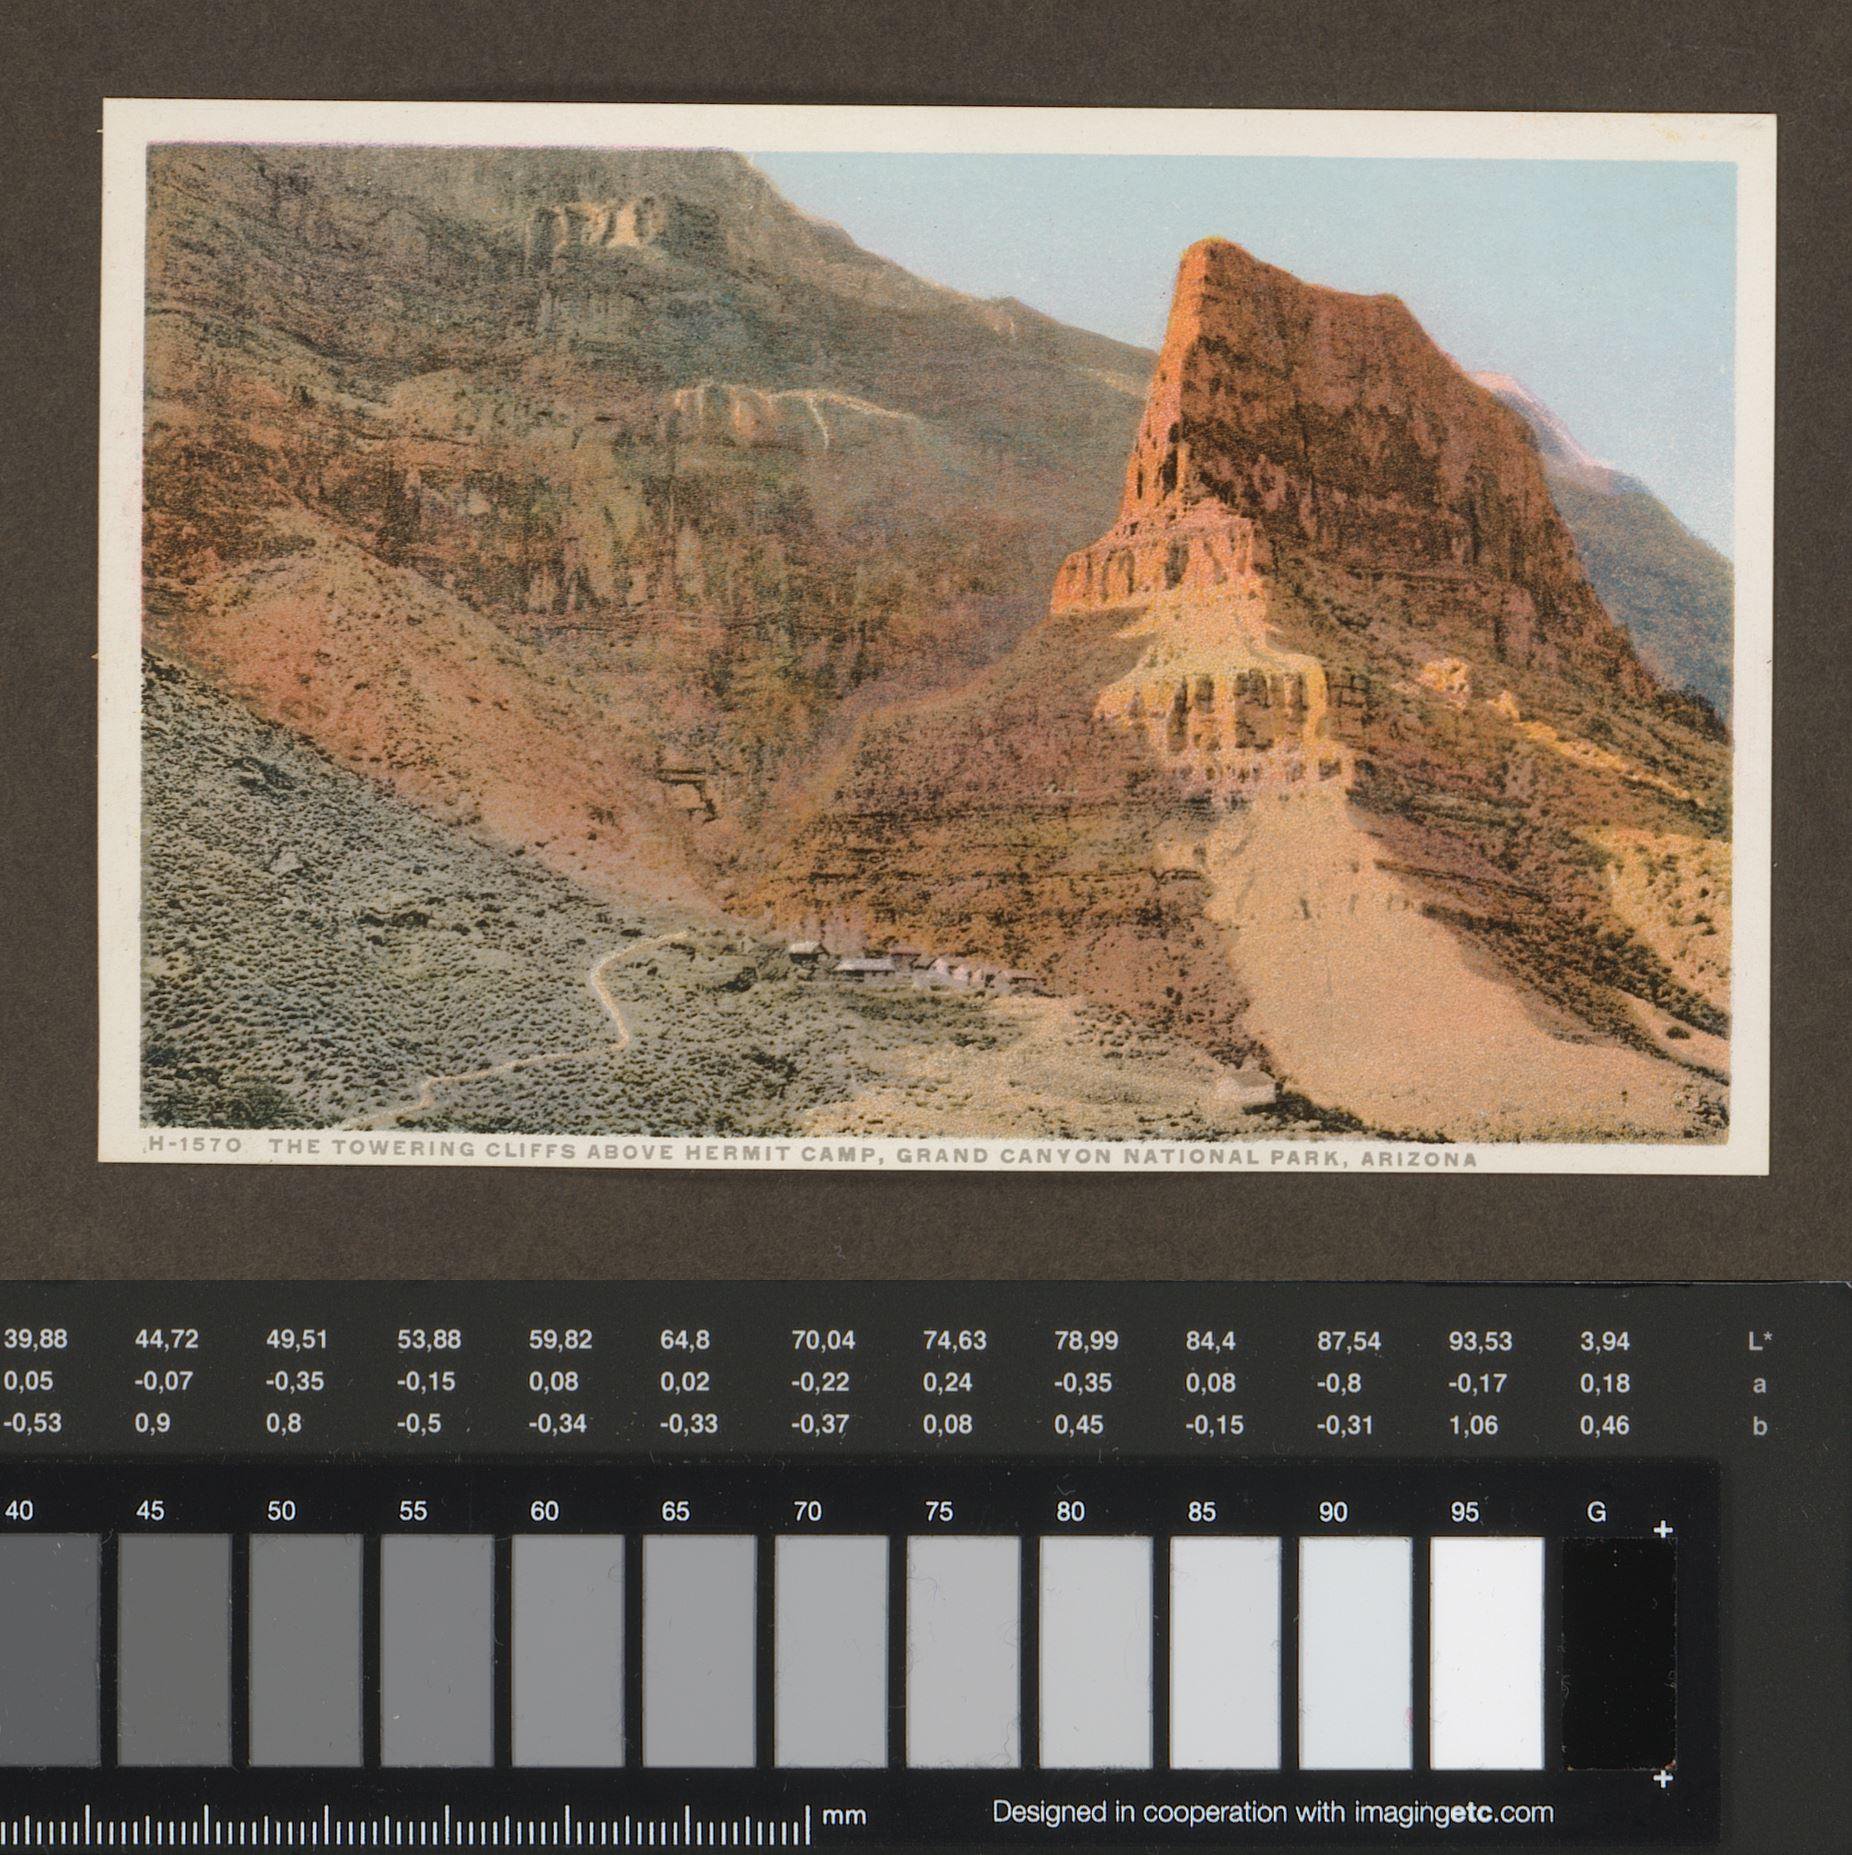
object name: ansichtkaart, prentbriefkaart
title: The towering cliffs above Hermit Camp, Grand Canyon National Park, Arizona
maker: Anonymous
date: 1928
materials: paper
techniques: chromolithography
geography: grand canyon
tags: shop, store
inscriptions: annotation: ‘Grand Canyon’, number: ‘H-1570’